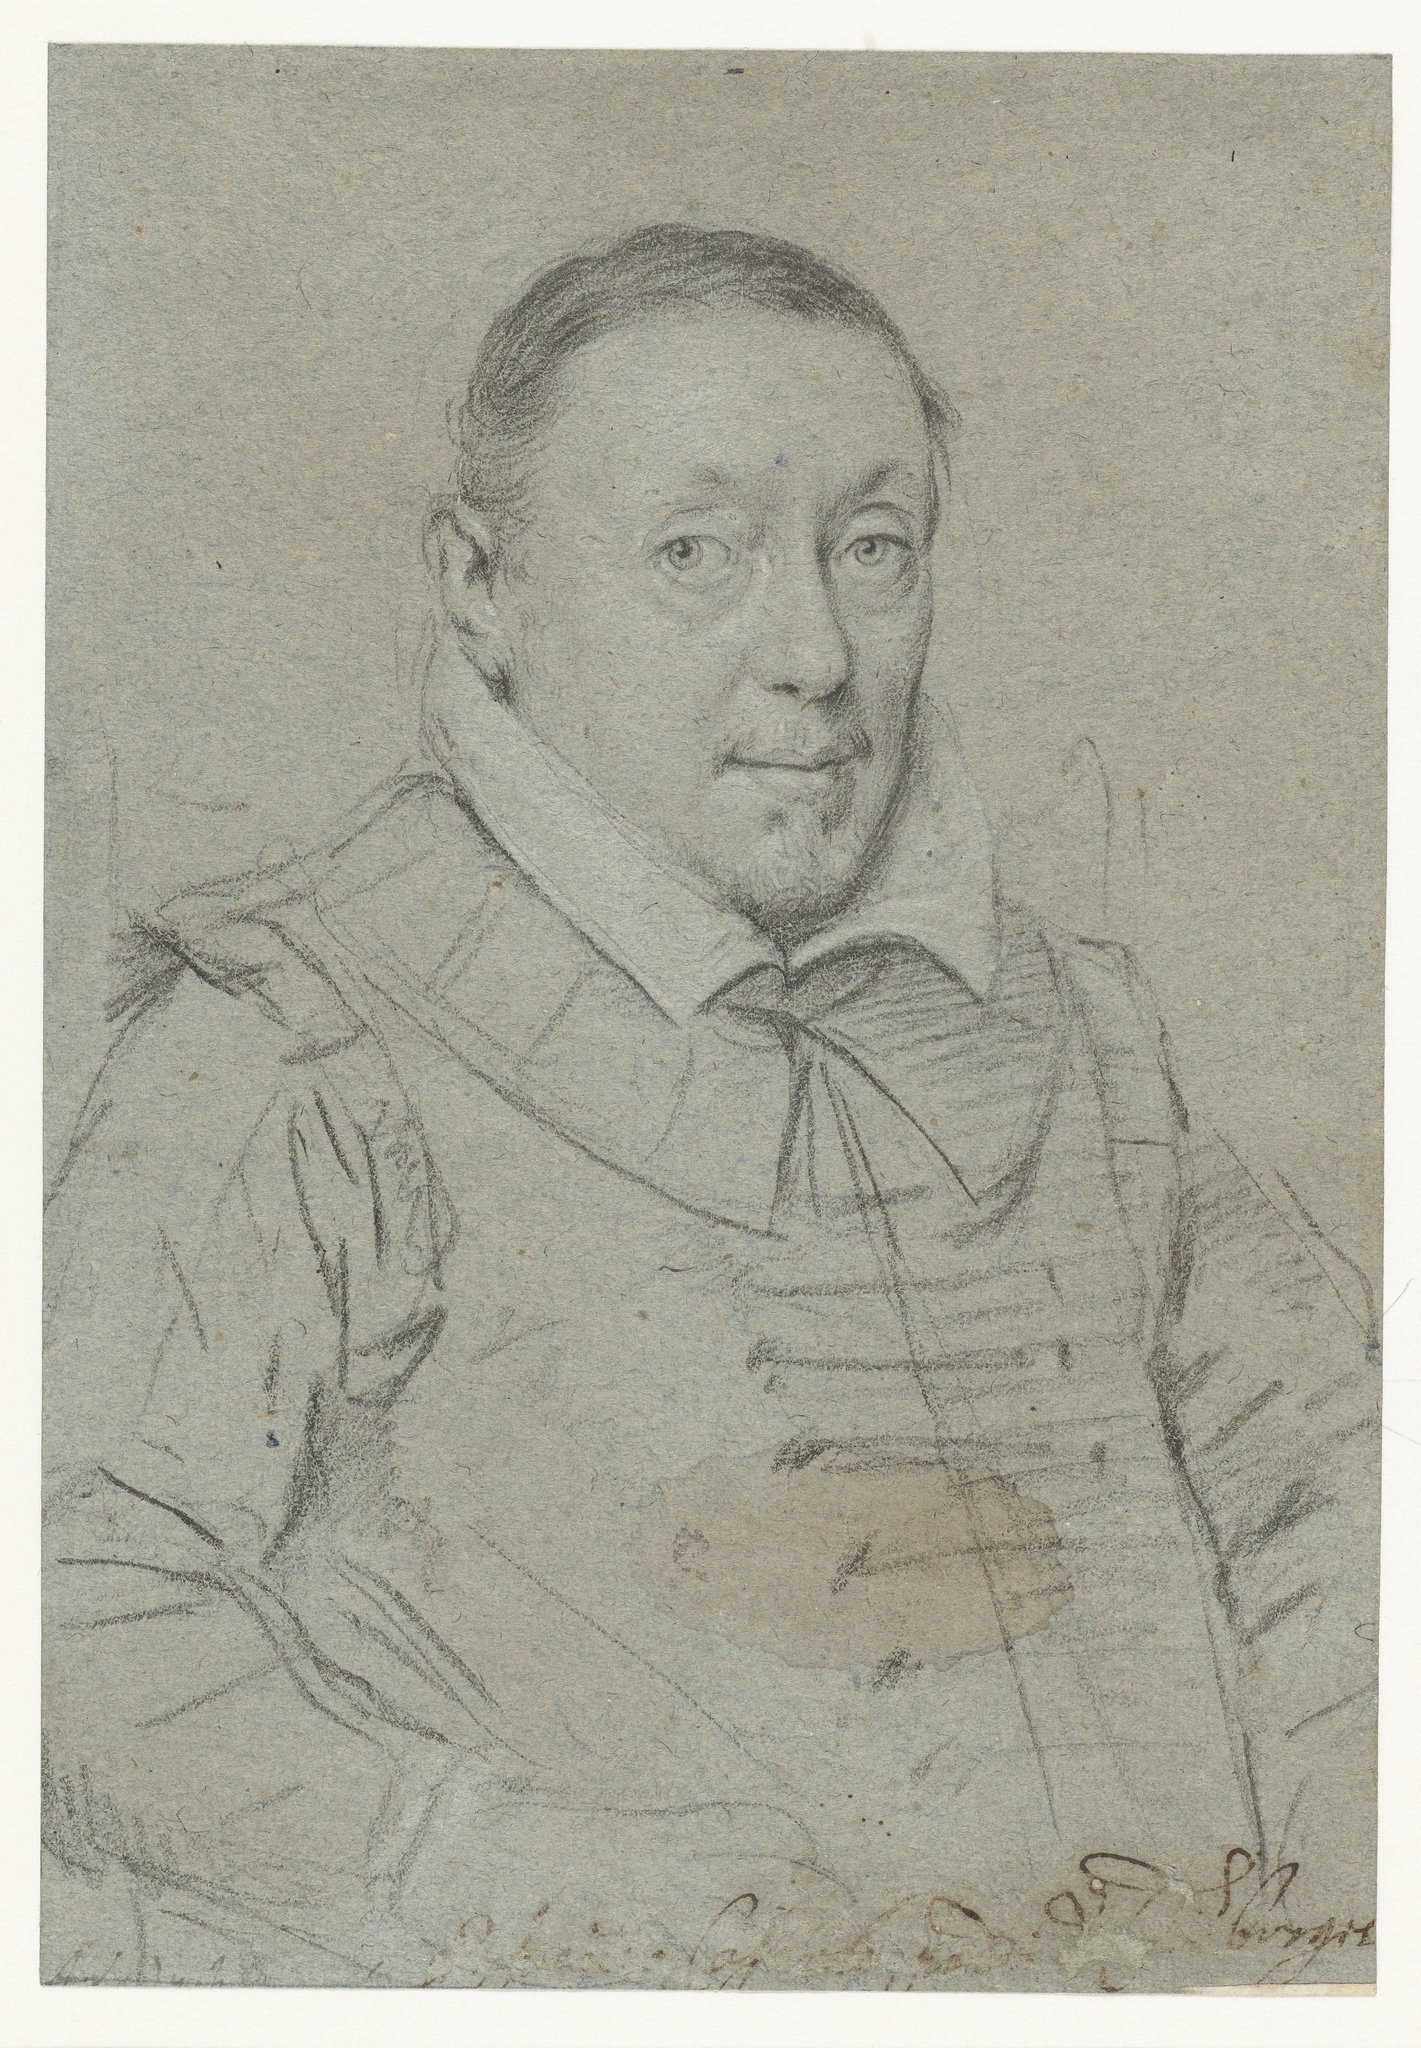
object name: drawing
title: Portret van een onbekende heer, ten halven lijve naar rechts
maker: ottavio mario leoni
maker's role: draughtsman, print maker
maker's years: 1578-1630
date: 1588-1614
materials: chalk, paper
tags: historical persons not known by name